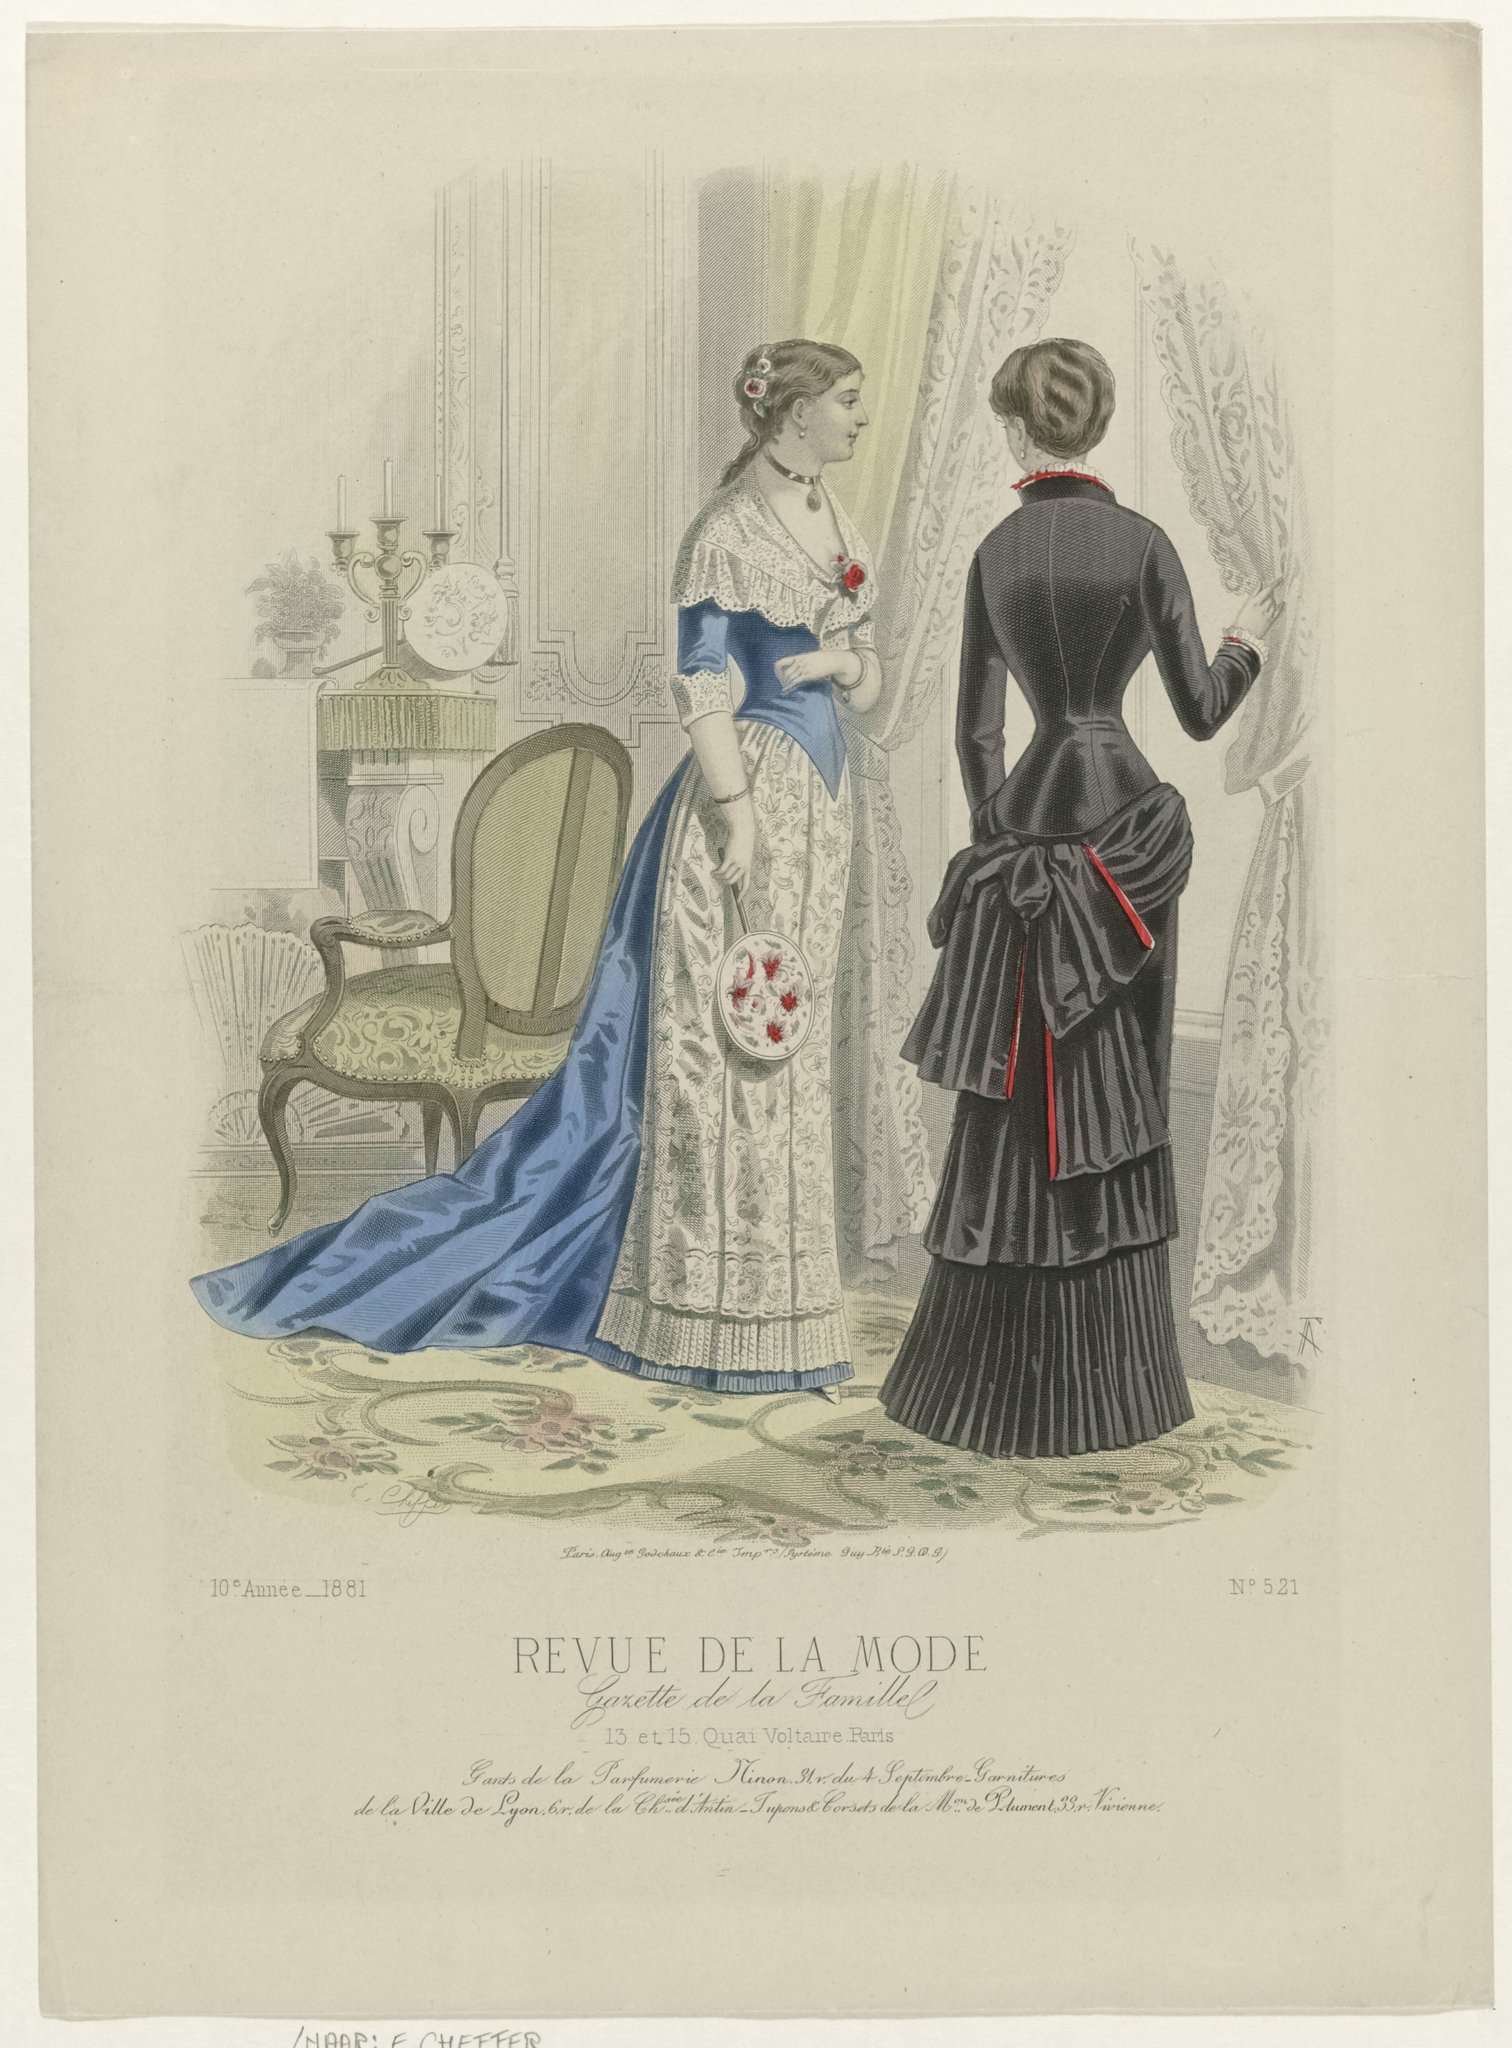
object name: fashion print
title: Revue de la Mode, Gazette de la Famille, dimanche 25 décembre 1881, 10e année, No. 521: Gants de la Parfumerie Ninon (...)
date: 1881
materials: paper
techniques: engraving, hand coloring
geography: paris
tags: bow (ornamental part of clothing) (+ women's clothes), corsage (+ women's clothes), pendant, trinket, 'breloque' (+ women's clothes), dress, gown: evening dress (+ women's clothes), neck-gear ~ clothing (neckerchief) (+ women's clothes), piece of clothing covering the breast or décolleté (fichu) (+ lace used for clothes), dress, gown (visiting dress) (+ women's clothes), dress, gown (robe d'intérieur) (+ women's clothes), open hearth, fire-place, fashion plates, human figure at (open) window, seen from inside, bracelet, wristlet (+ women's clothes)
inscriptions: caption: ‘Gants de la Parfumerie Ninon, 31, r. du 4 Septembre_ Garnitures de la Ville de Lyon, 6, r. de la Ch.sée d'Antin_ Jupons & Corsets de la M.on de Plument, 33, r. Vivienne’, address: ‘13 et 15, Quai Voltaire, Paris’, title: ‘REVUE DE LA MODE / Gazette de la Famille’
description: Twee vrouwen in een interieur, staand bij een raam. Links: japon van blauw velours en wit brokaat met goudkleurig bloemmotief, voor soirées en recepties. Fichu van kant. De vrouw houdt een handscherm (vuurscherm) met bloemmotief in de hand. Rechts: huisjapon en japon voor visites van zwart satijn. Onder de afbeelding enkele regels reclametekst voor verschillende producten. Prent uit het modetijdschrift Revue de la Mode (1872-1913). Uitgebreide beschrijving van de kleding op pagina 428 en 429 "PLANCHE COLORIÉE".